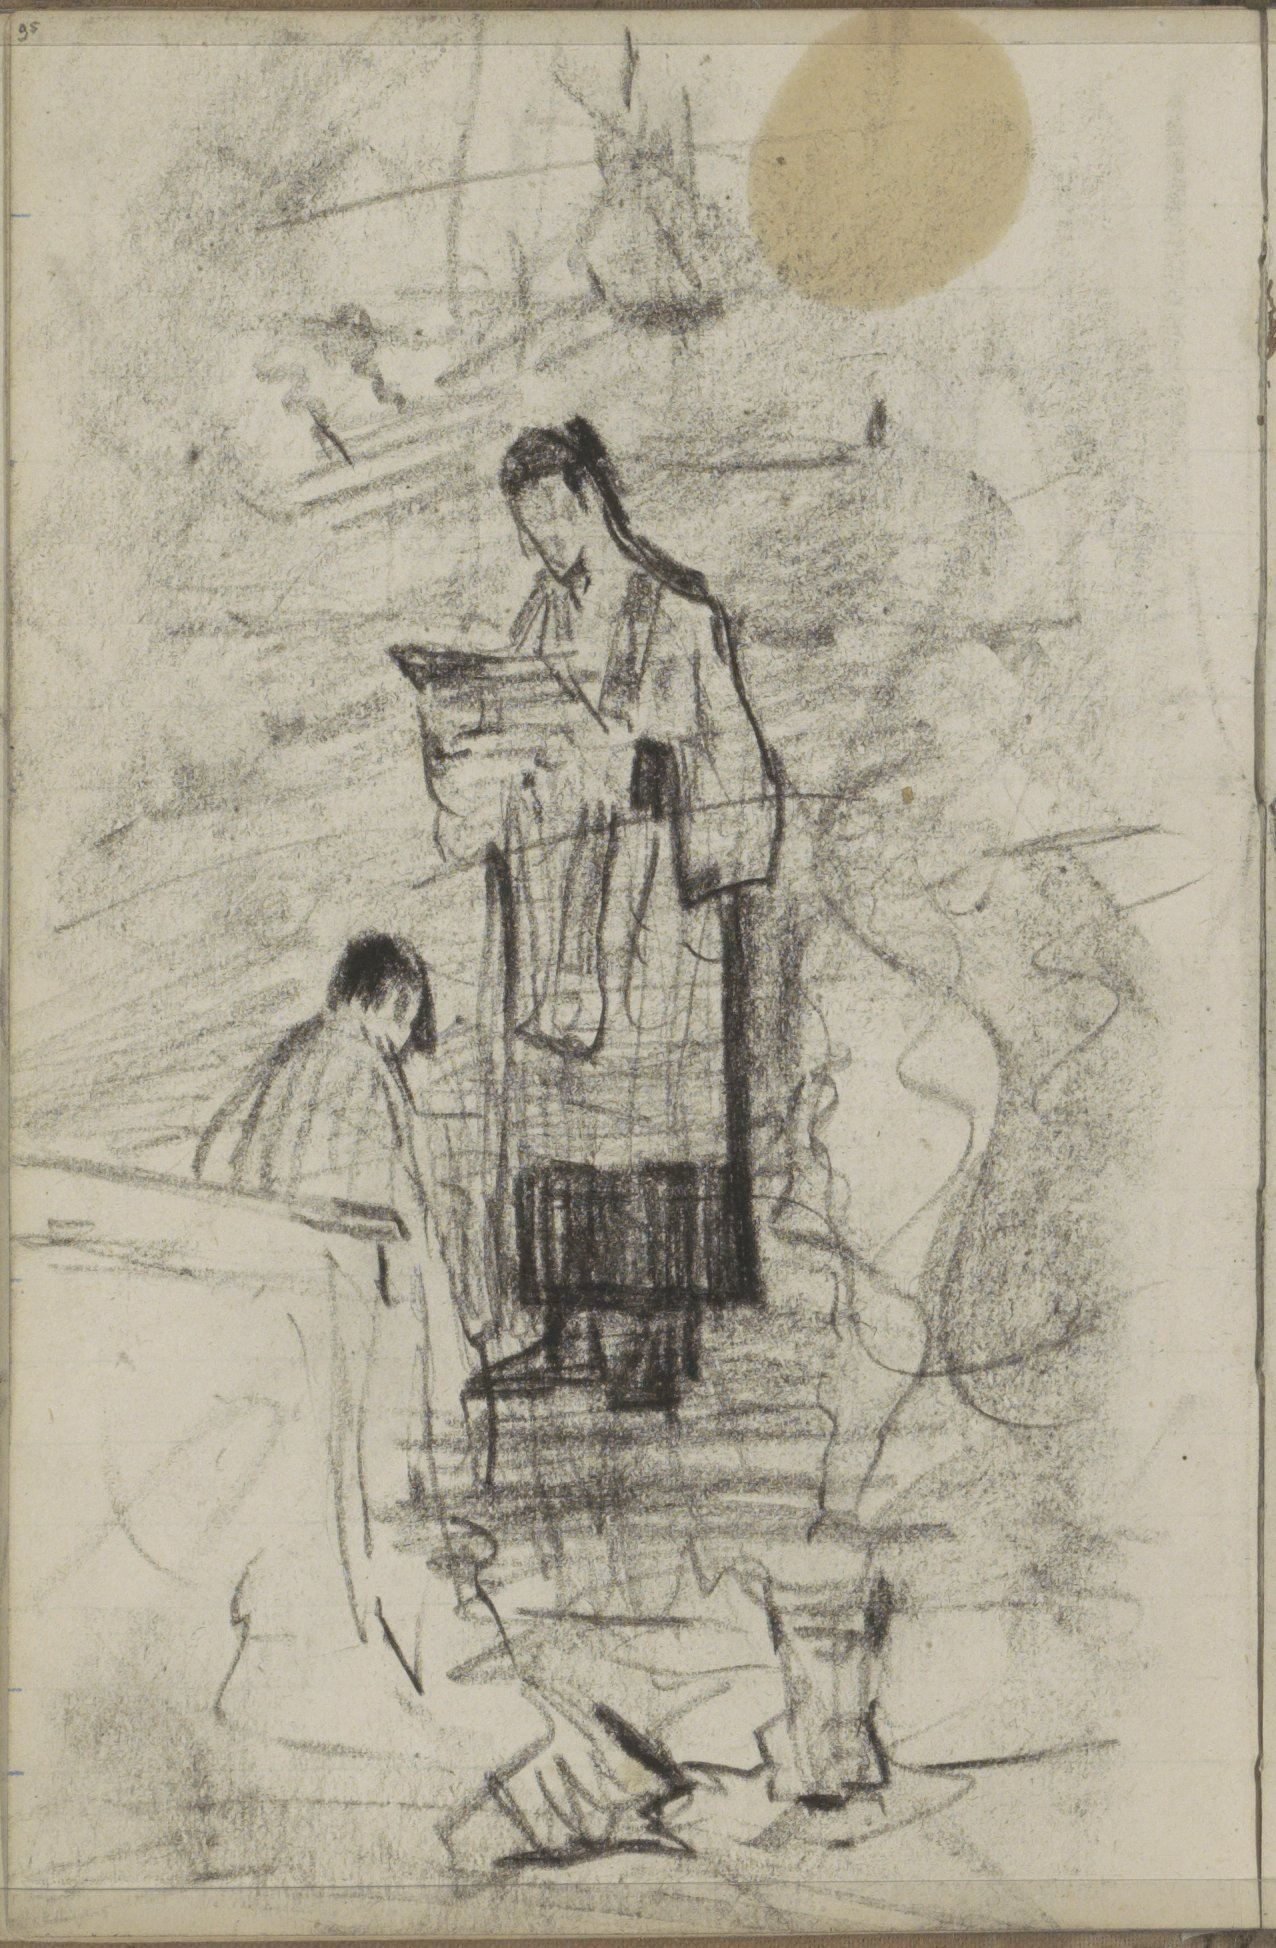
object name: sketchbook leaf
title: Staande lezende figuur in oosterse kleding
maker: marius bauer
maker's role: draughtsman, print maker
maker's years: 1867-1932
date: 1888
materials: chalk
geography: istanbul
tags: asiatic races and peoples, standing figure, sitting figure, reading to somebody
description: Op de voorgrond tevens een zittende figuur die mogelijk luistert naar de lezende figuur. Pagina 95 uit een schetsboek met 56 bladen.